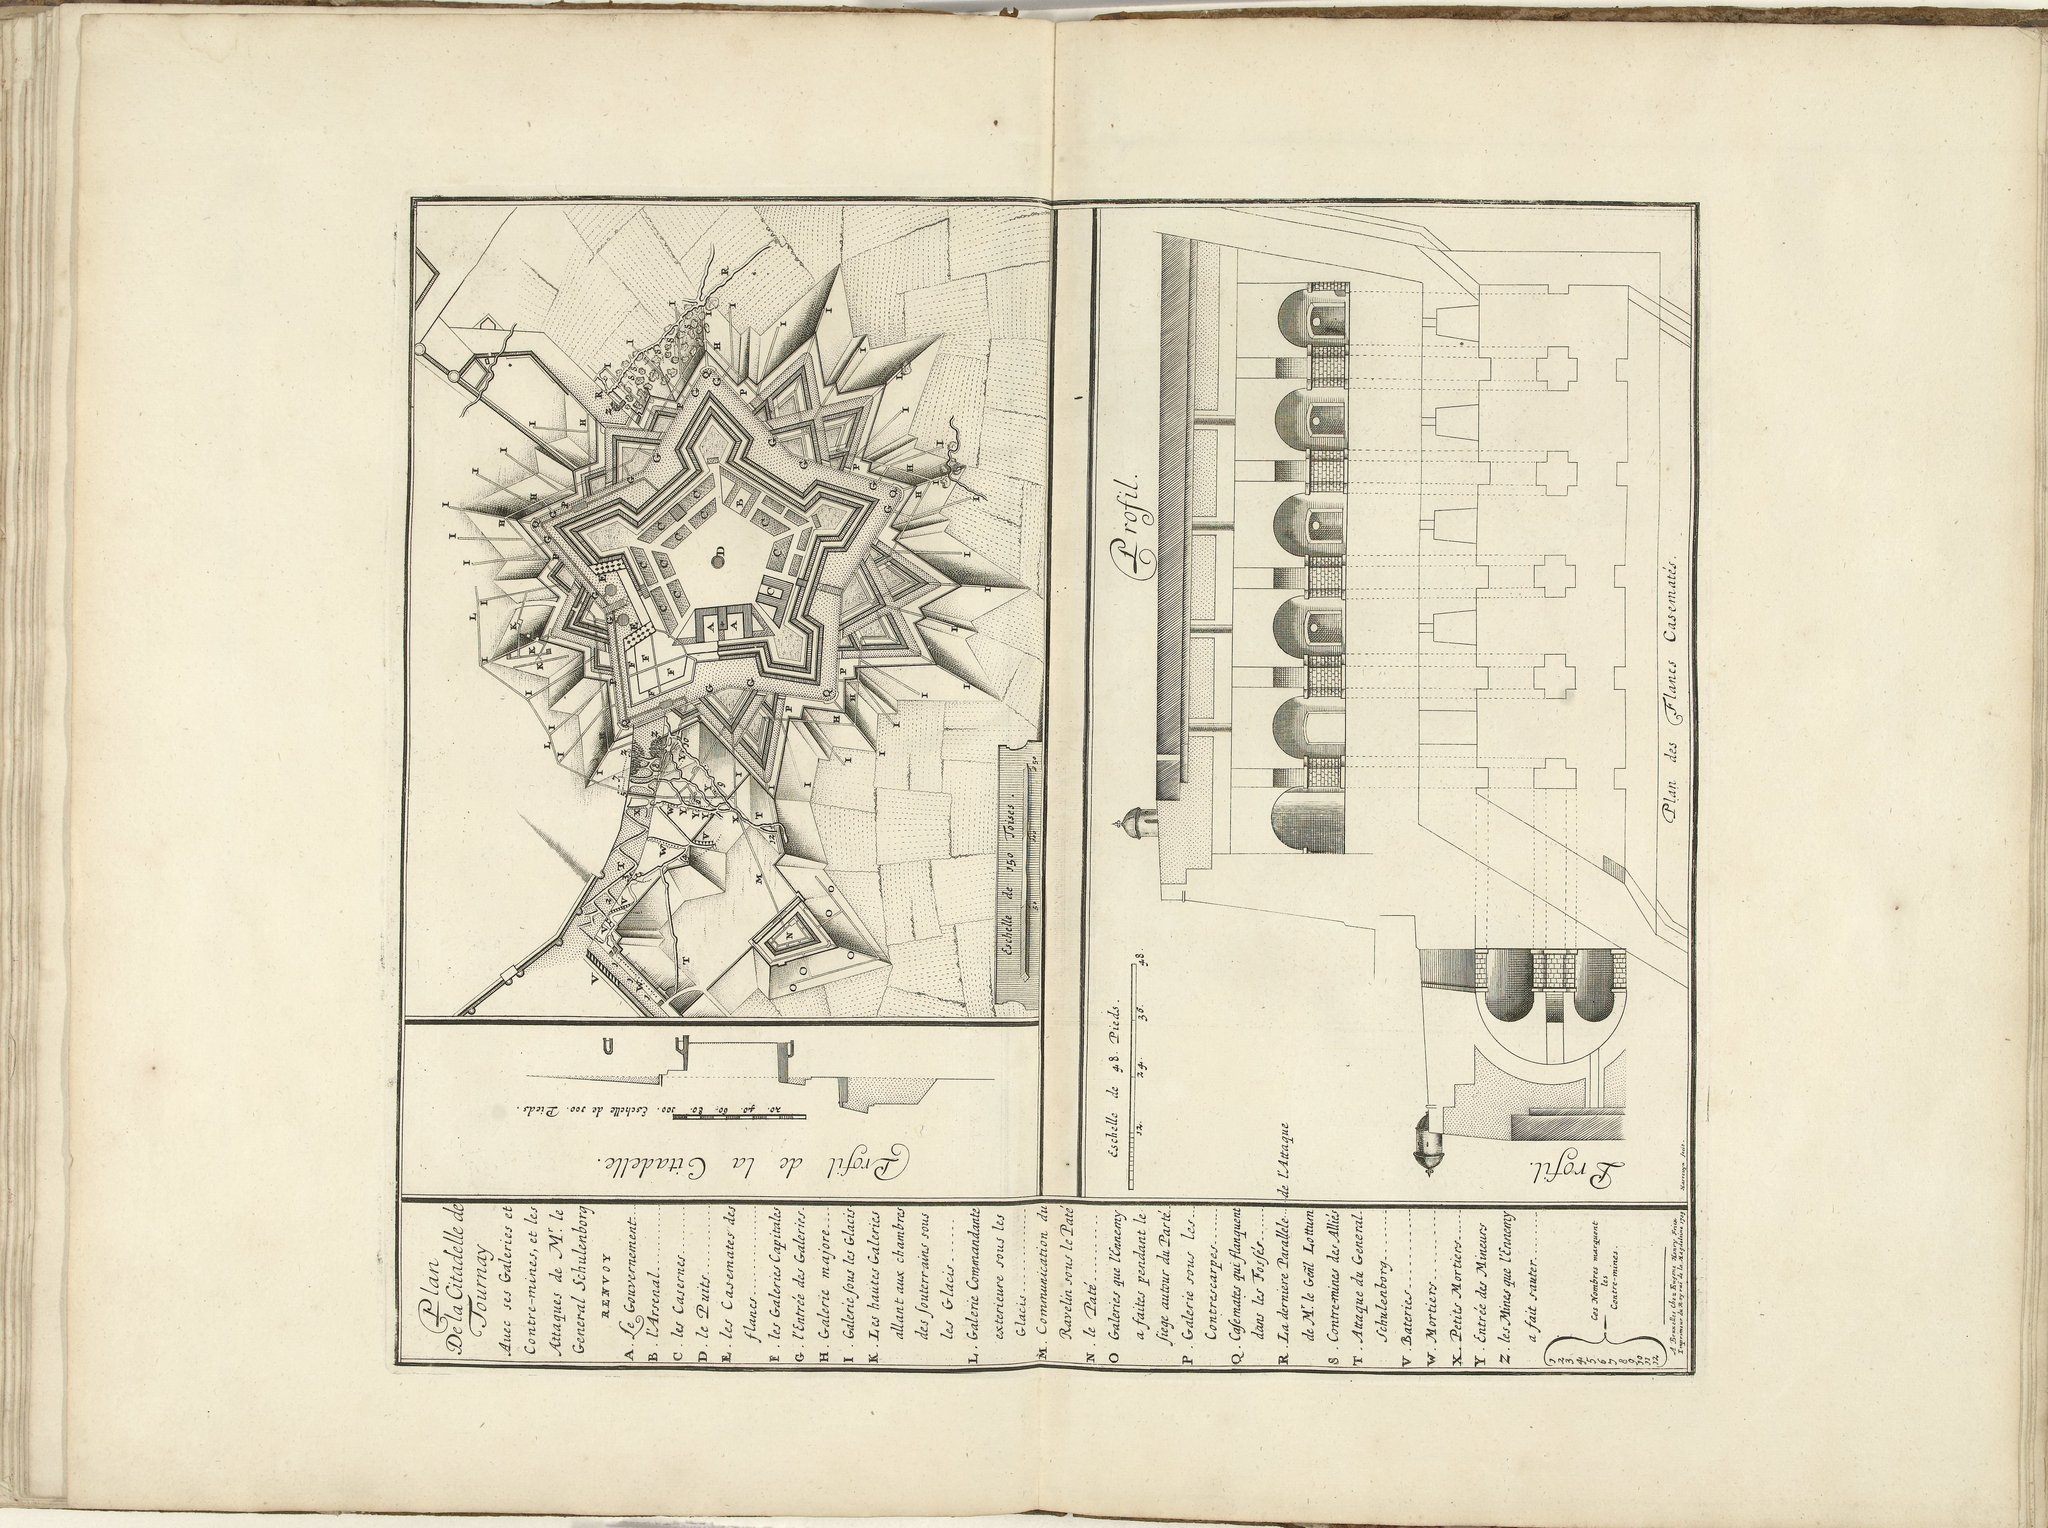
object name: print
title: Plan De la Citadelle de Tournay Avec ses Galeries et Contre-mines, et les Attaques de Mr. le General Schulenborg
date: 1709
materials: paper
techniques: engraving, etching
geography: brussels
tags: fortress, maps of cities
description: Plattegrond en doorsnede van de citadel van Tournai (Doornik), belegerd door de Geallieerden onder de hertog van Marlborough en de prins van Savoye vanaf 29 juni en ingenomen op 2 september 1709. Aan de linkerzijde de legenda A-Z. Onderdeel van een gebundelde verzameling van plannen van veldslagen en steden vermaard in de Spaanse Successieoorlog.